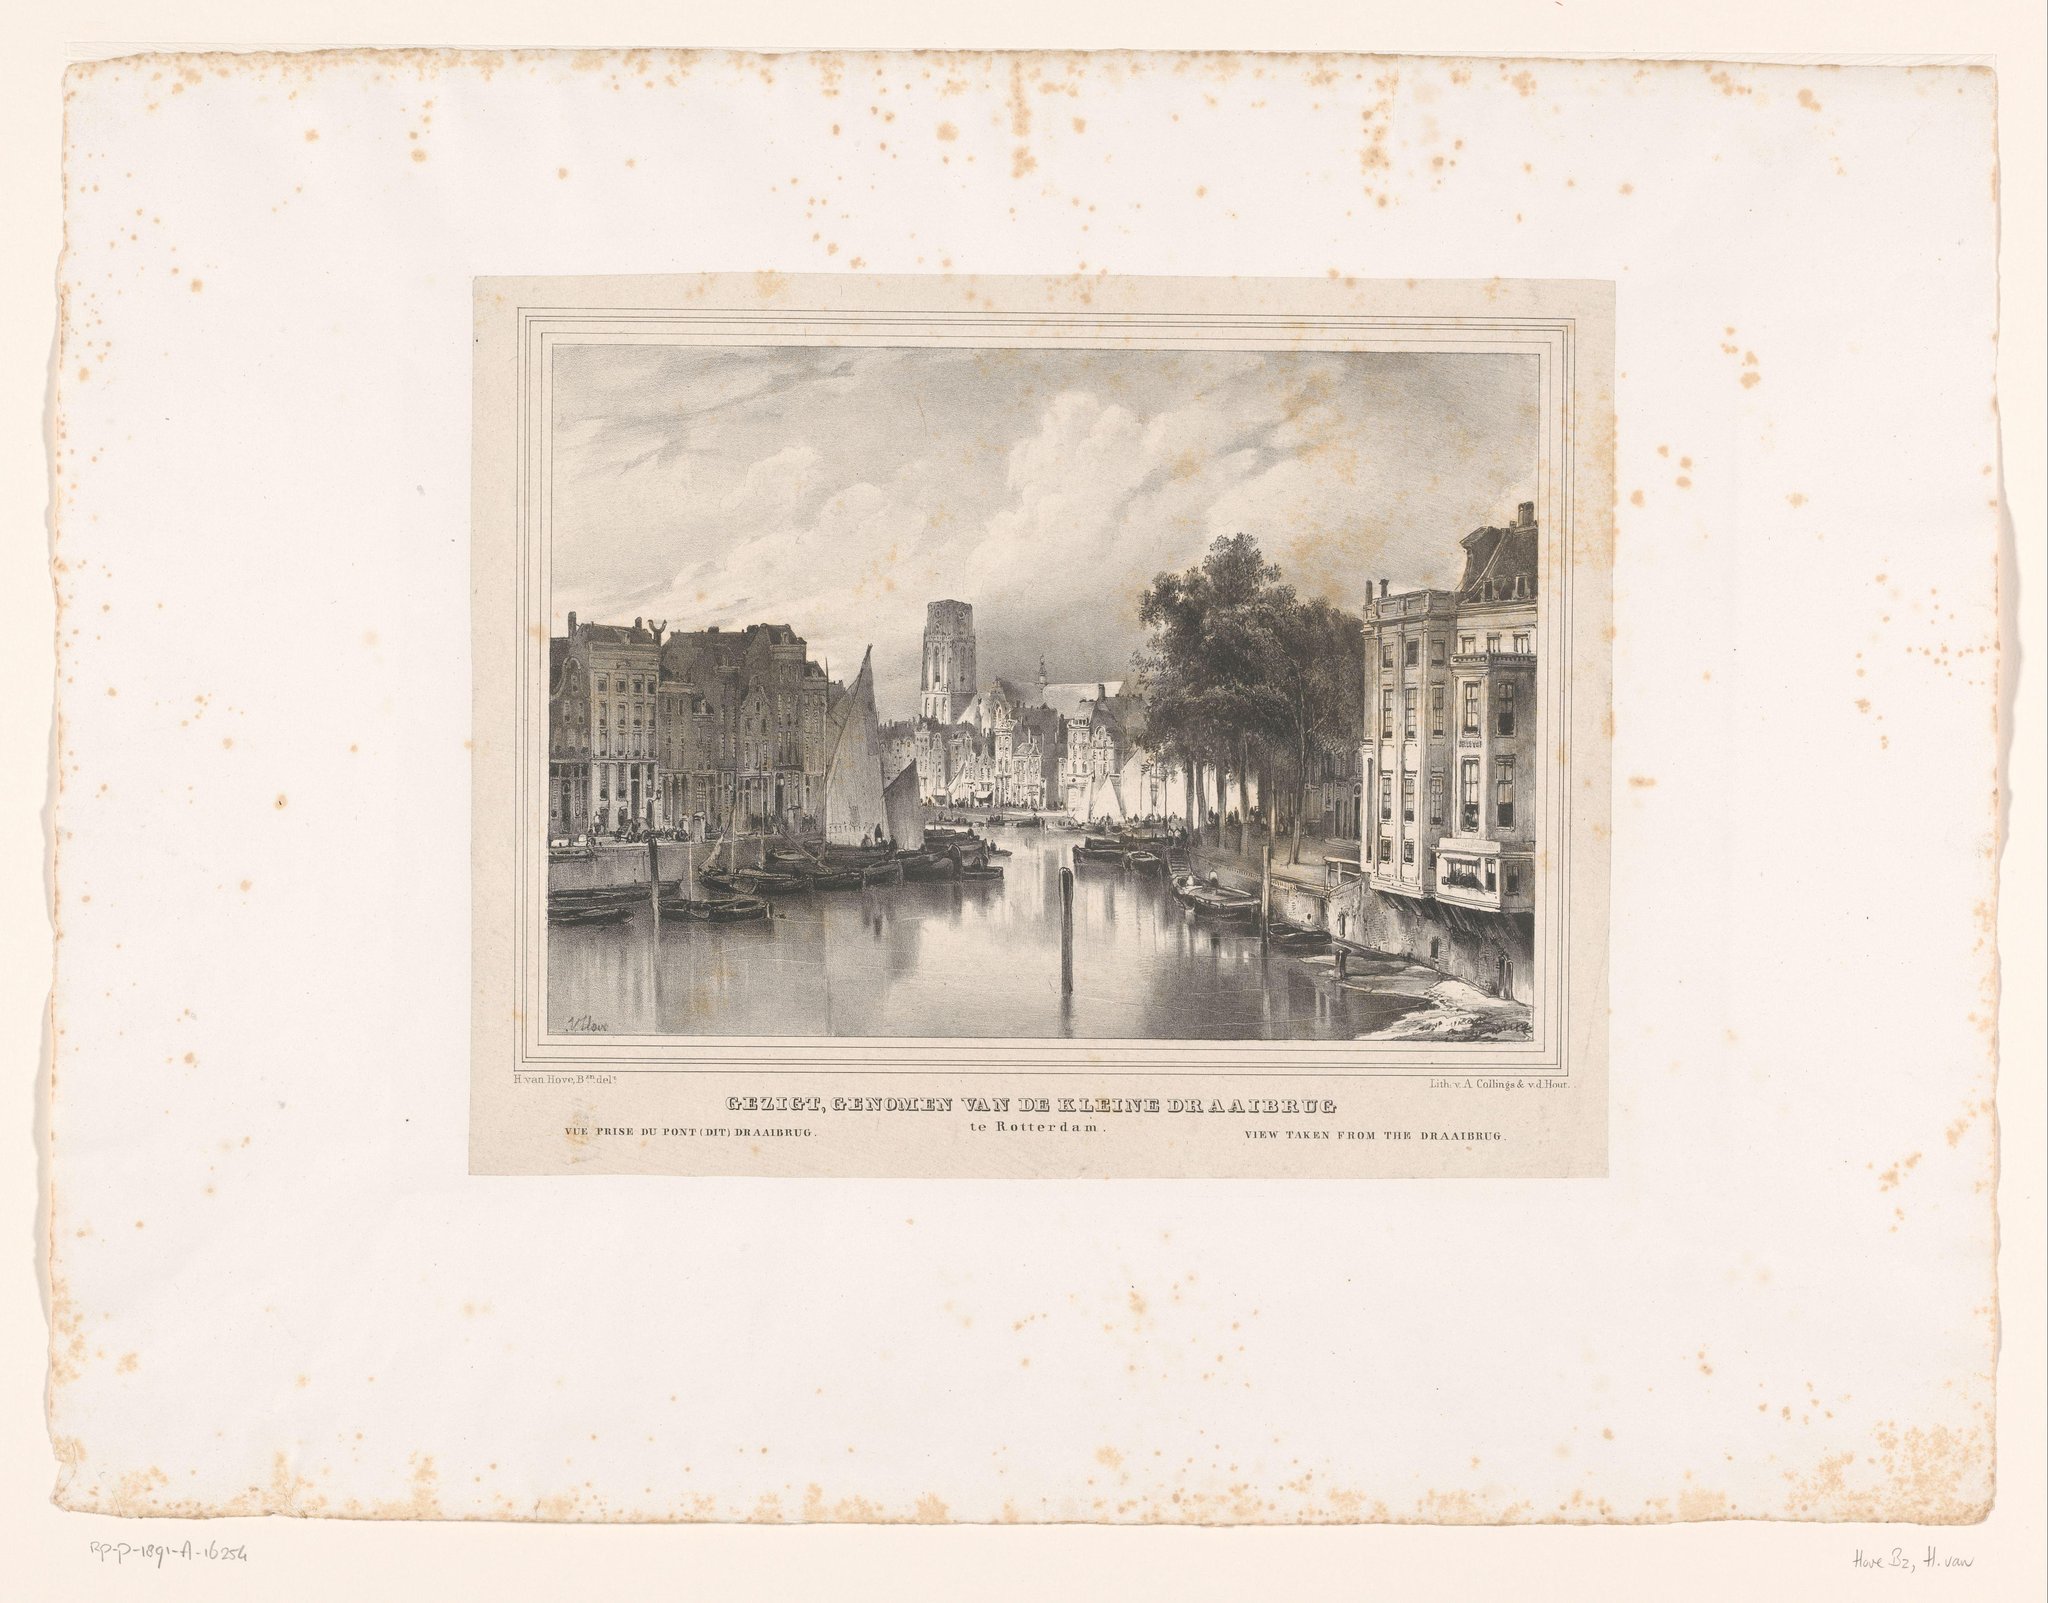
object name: print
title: Gezicht op Rotterdam gezien vanaf de Draaibrug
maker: huib van hove bz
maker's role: painter, print maker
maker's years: 1814-1867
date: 1835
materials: paper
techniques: lithograph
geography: rotterdam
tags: city-view in general; 'veduta'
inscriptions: collector's mark: Lugt 2228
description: Gezicht op de Kolk met in de achtergrond de Grote of Sint-Laurenskerk, gezien vanaf de (Kleine) Draaibrug te Rotterdam. Prent is onderdeel van een omslag met een serie van acht lithografieën van gezichten te Rotterdam.